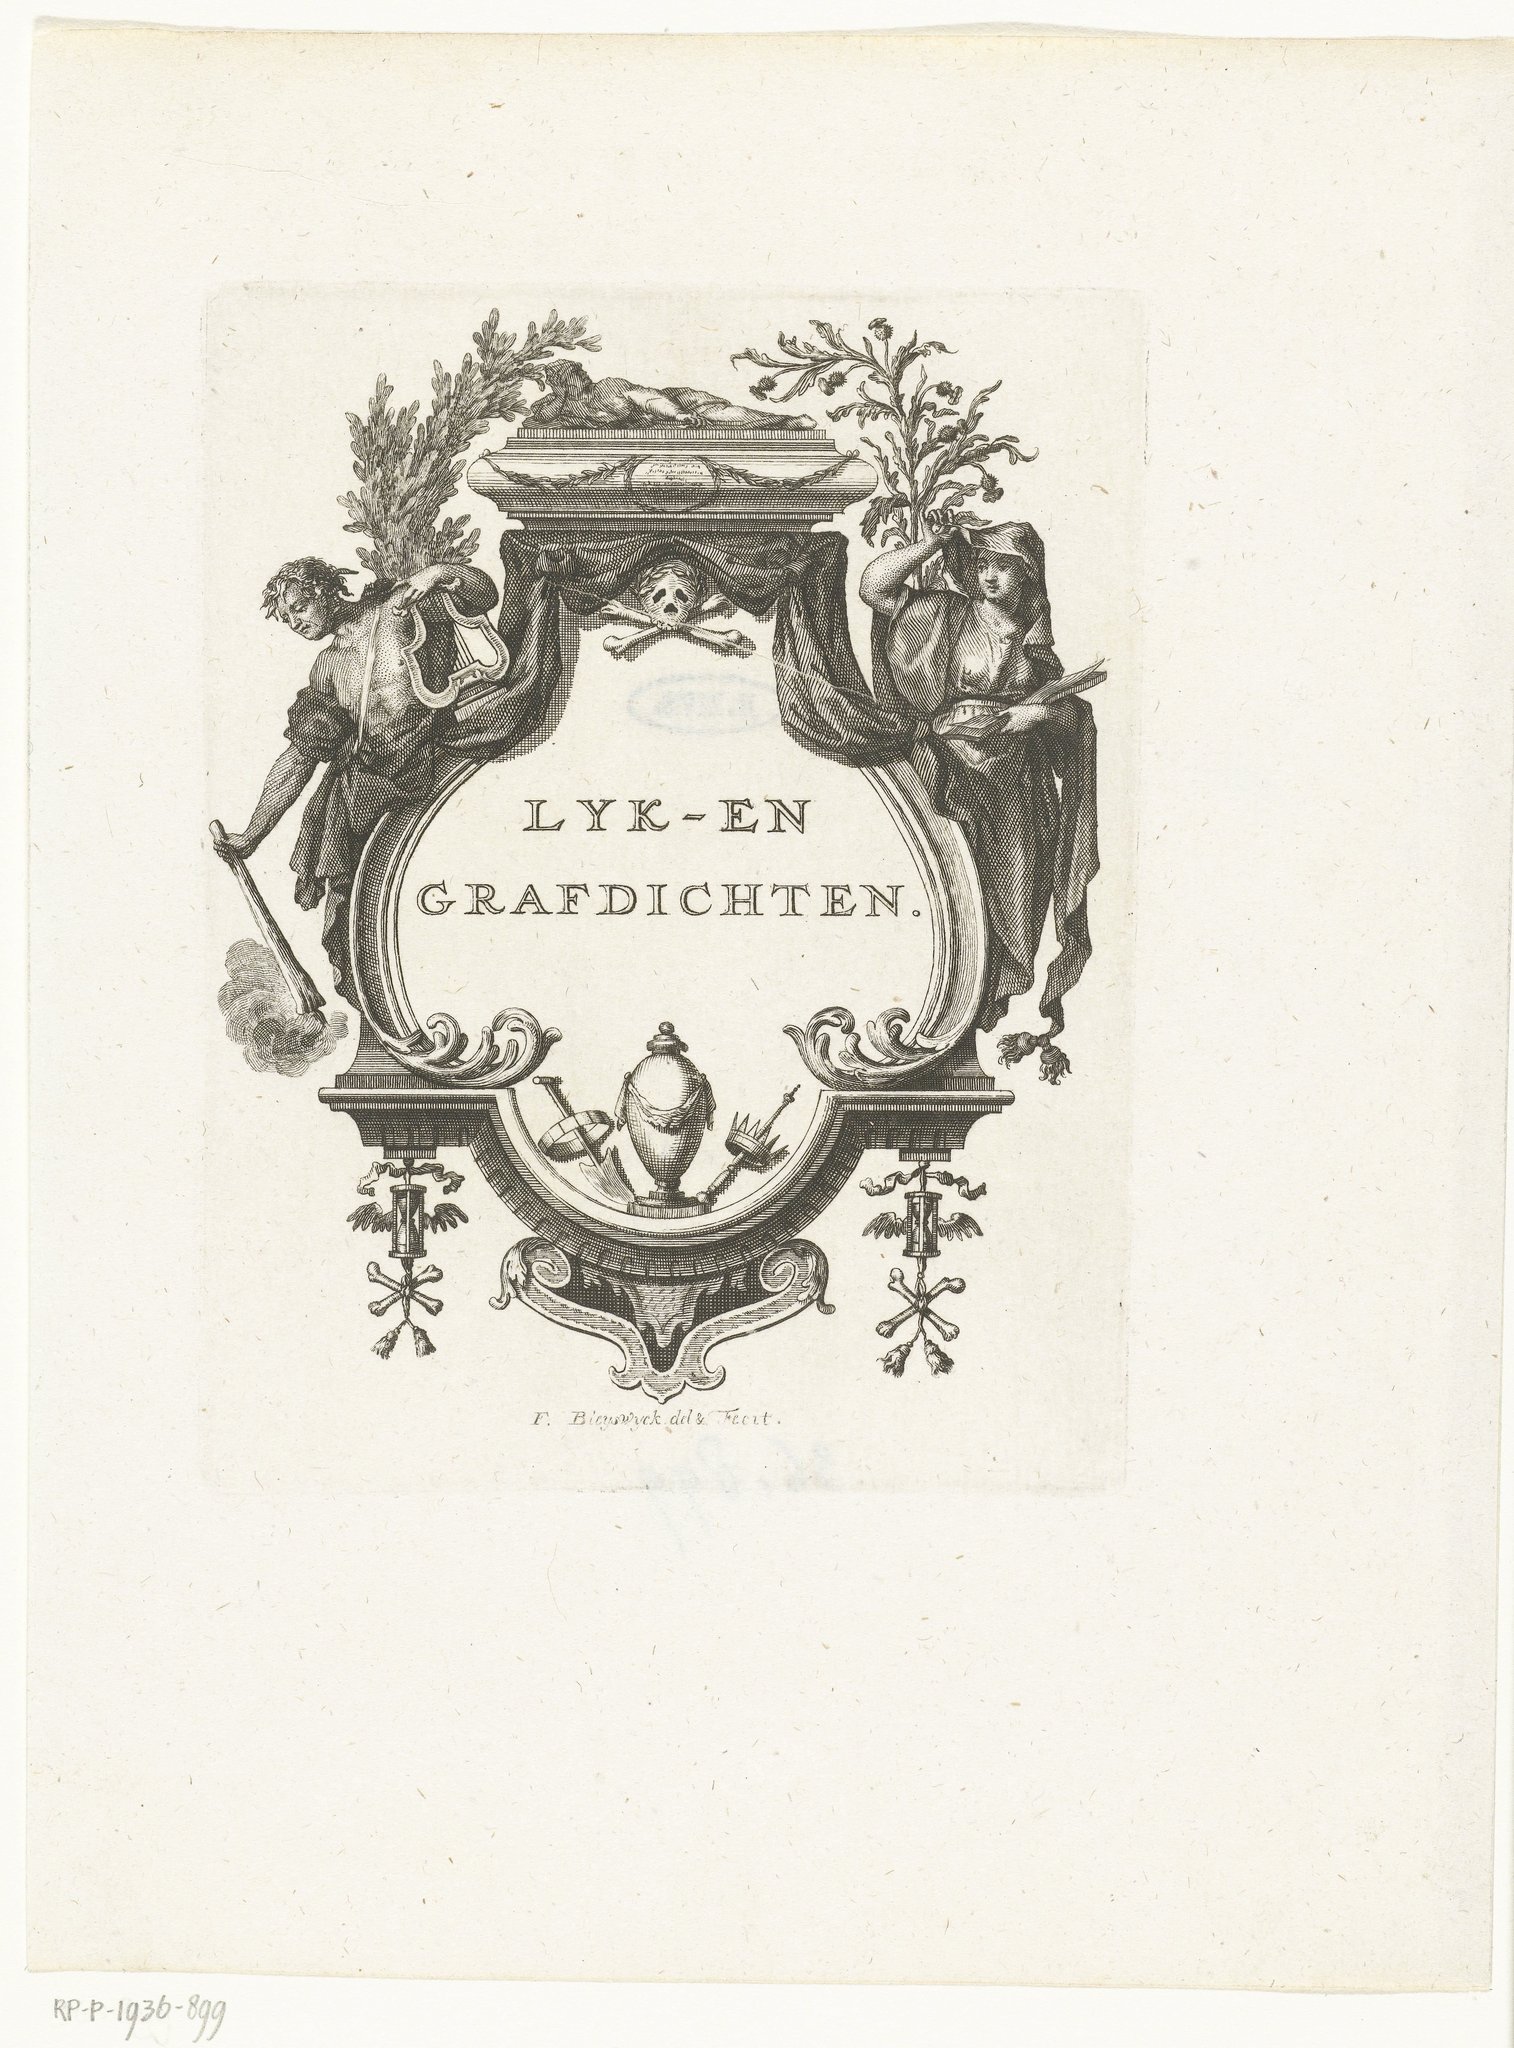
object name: print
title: Titelvignet met omlijsting waarin graftombe en treurende figuren zijn opgenomen en symbolen van vergankelijkheid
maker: françois van bleyswijck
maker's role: draughtsman, print maker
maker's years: 1671-1746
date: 1681-1720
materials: paper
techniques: etching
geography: leiden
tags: 'vanitas' symbols, grave, tomb, lamentation (~ burial rites)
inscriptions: collector's mark: Lugt 2760, collector's mark: Lugt 2228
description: Titelvignet met omlijsting waarin graftombe met liggende figuur en een treurende man en vrouw zijn opgenomen. Een schedel, een gedoofde fakkel en gevelugelde zandlopers verwijzen naar de vergankelijkheid.